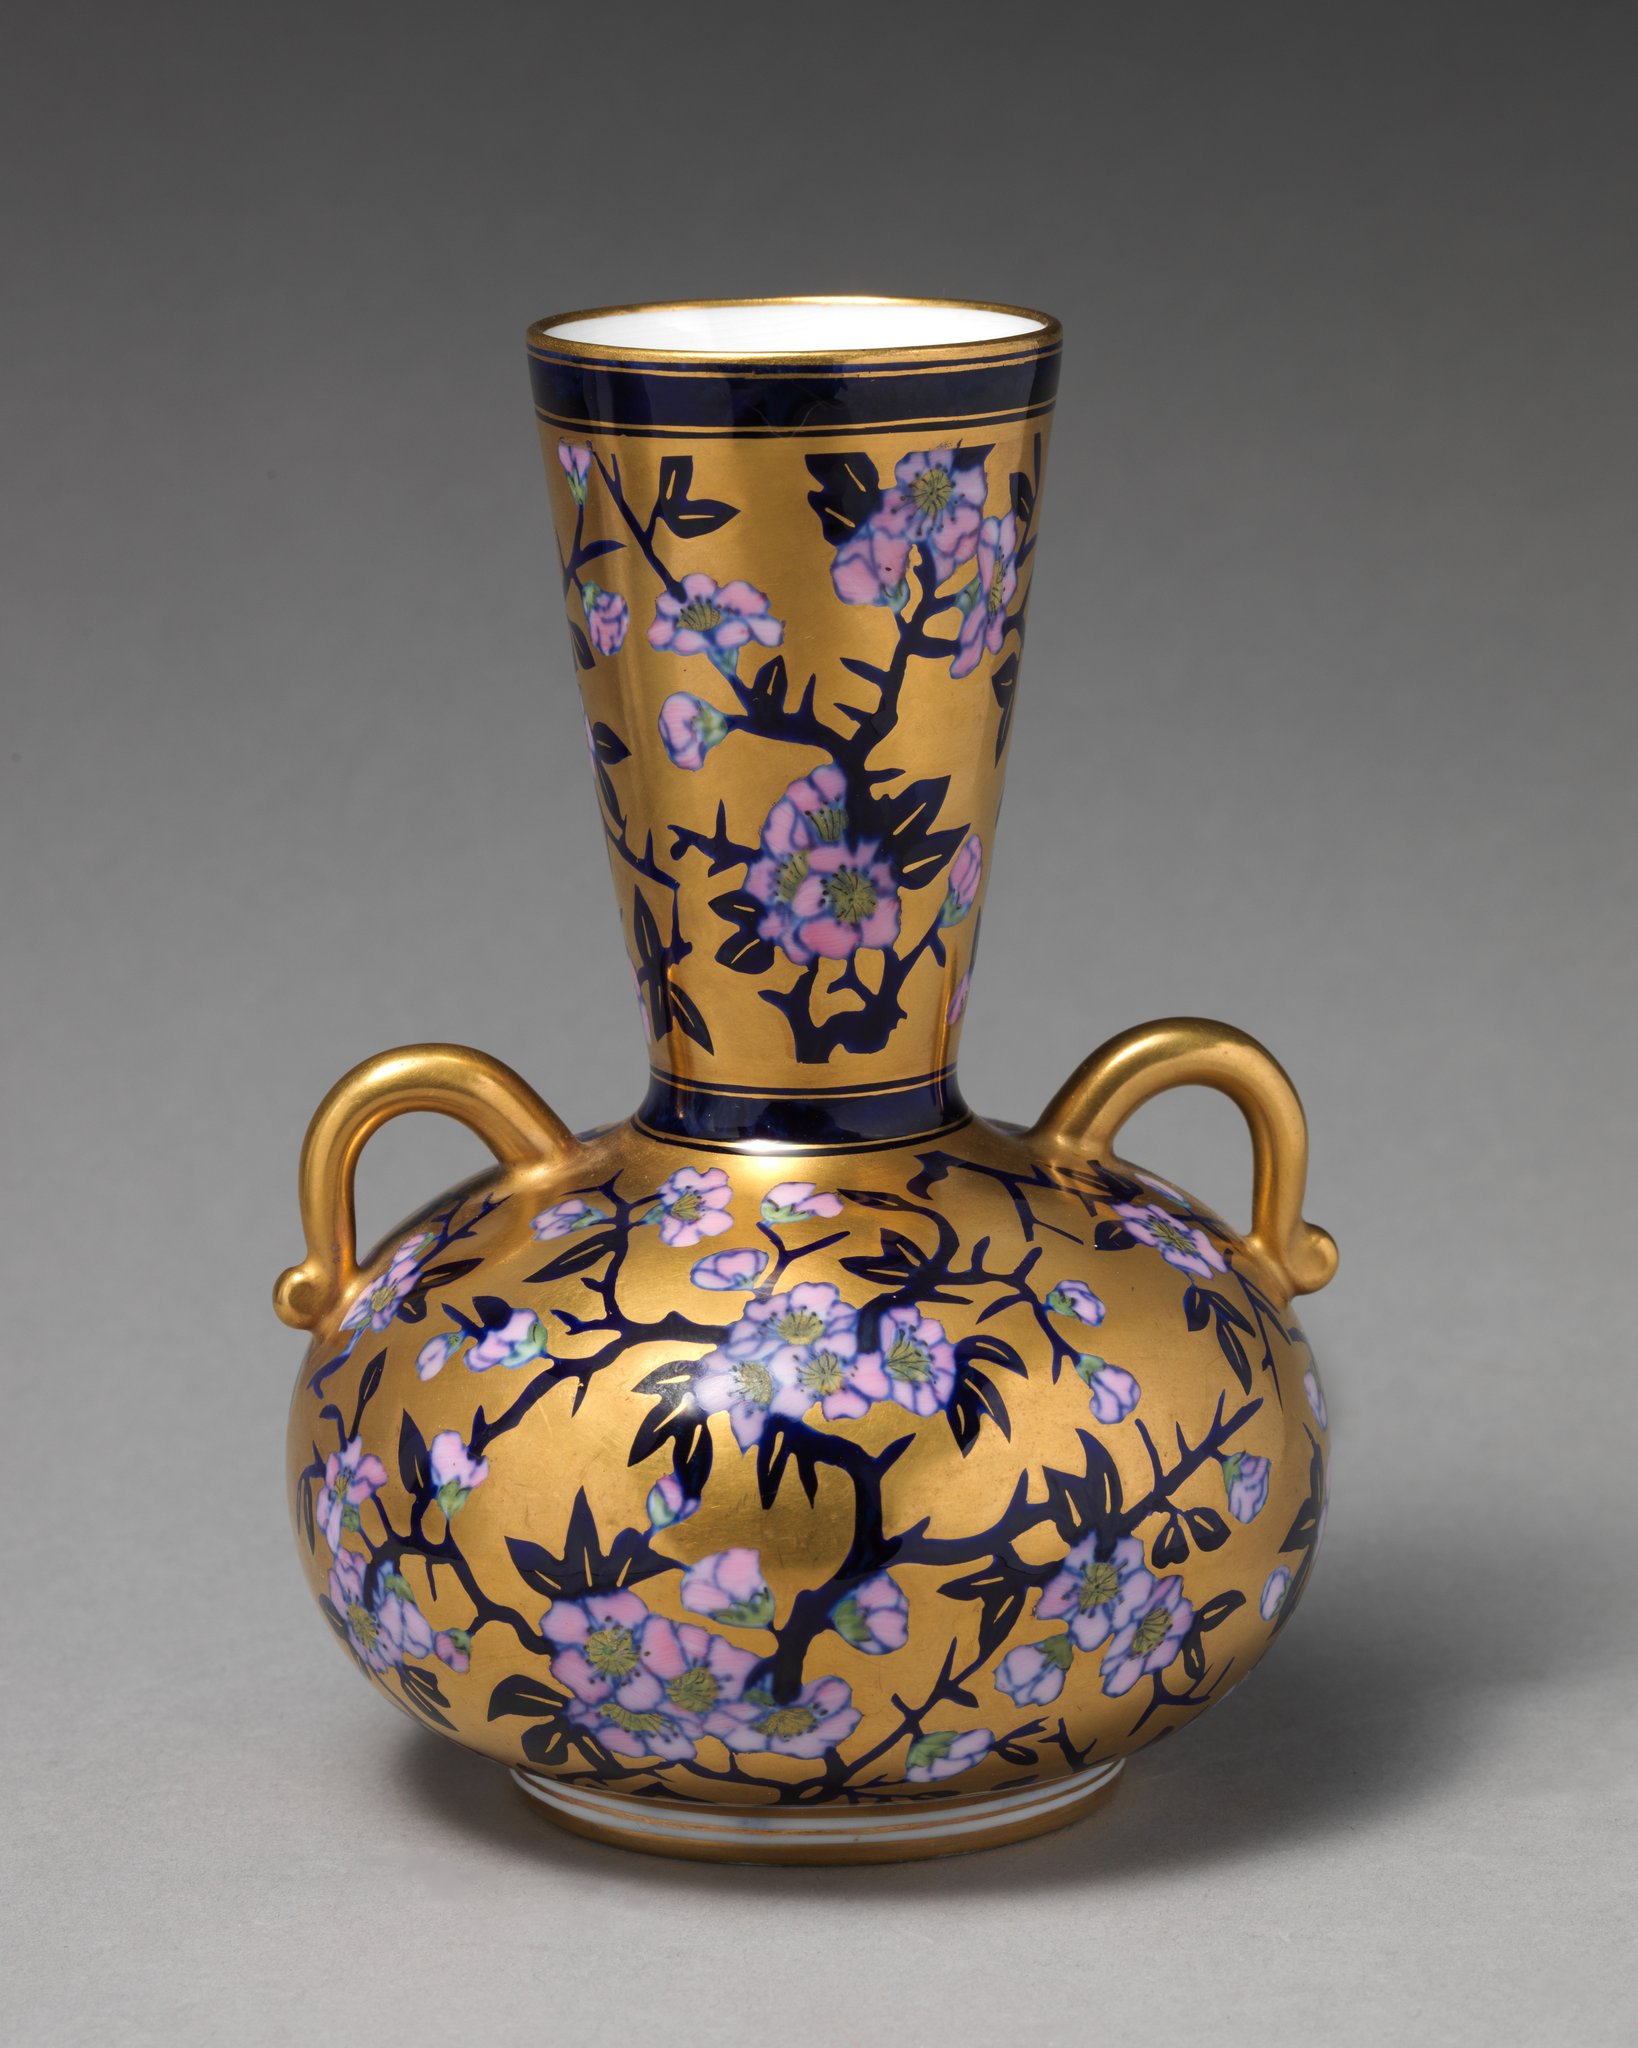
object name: vase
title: Vase with branch of white blossom (one of a pair)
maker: coalport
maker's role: maker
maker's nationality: british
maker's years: 1794-1926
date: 1870-1879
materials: porcelain